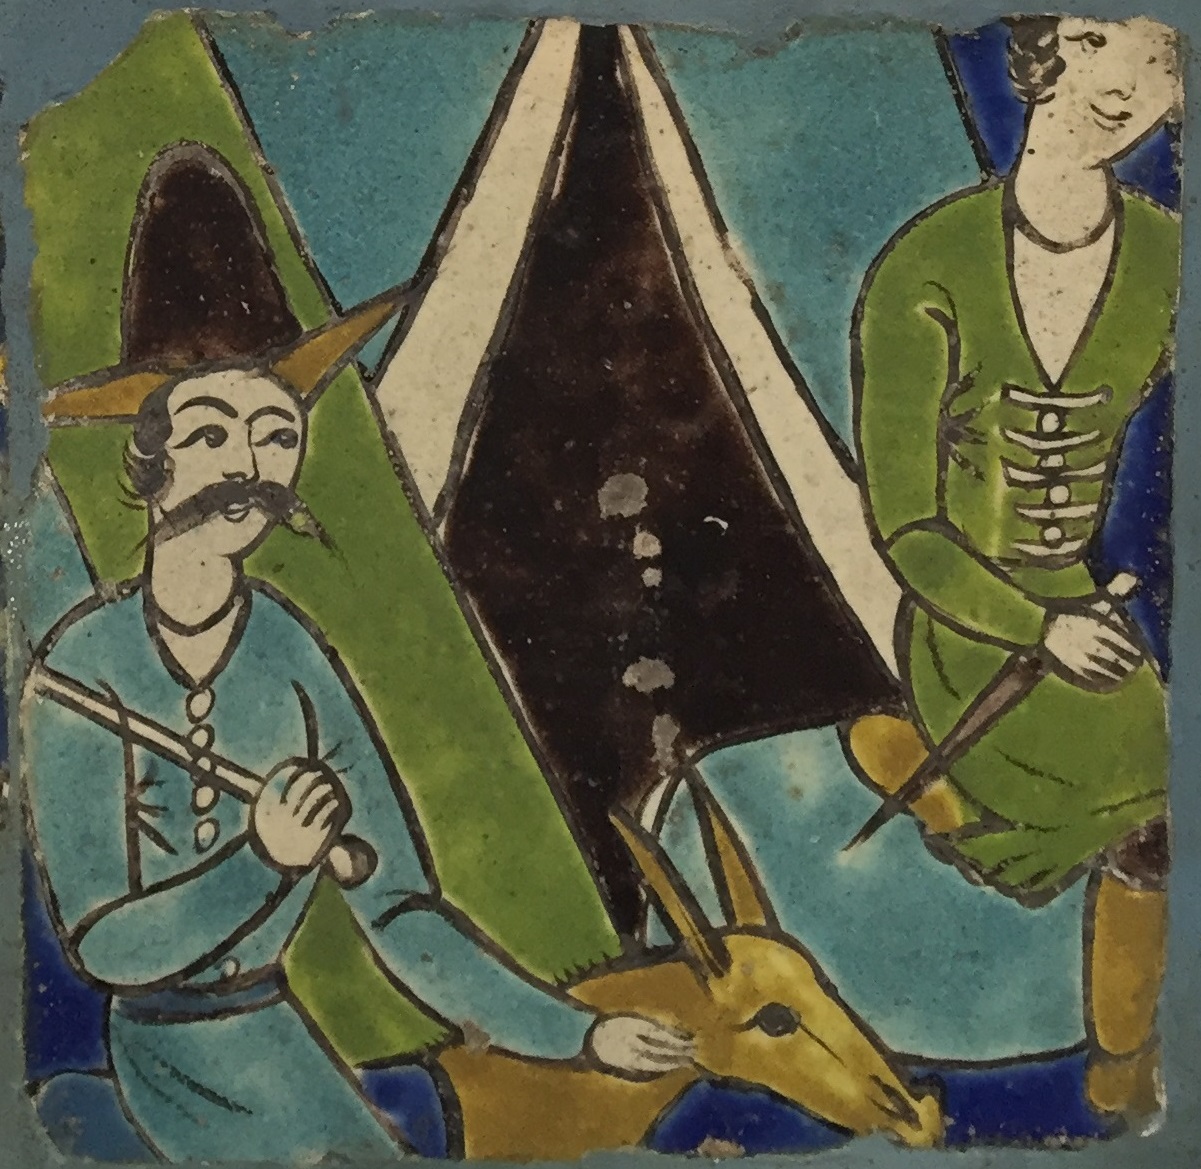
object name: tile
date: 1701-1800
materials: stonepaste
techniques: glazing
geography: iran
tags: animals,men